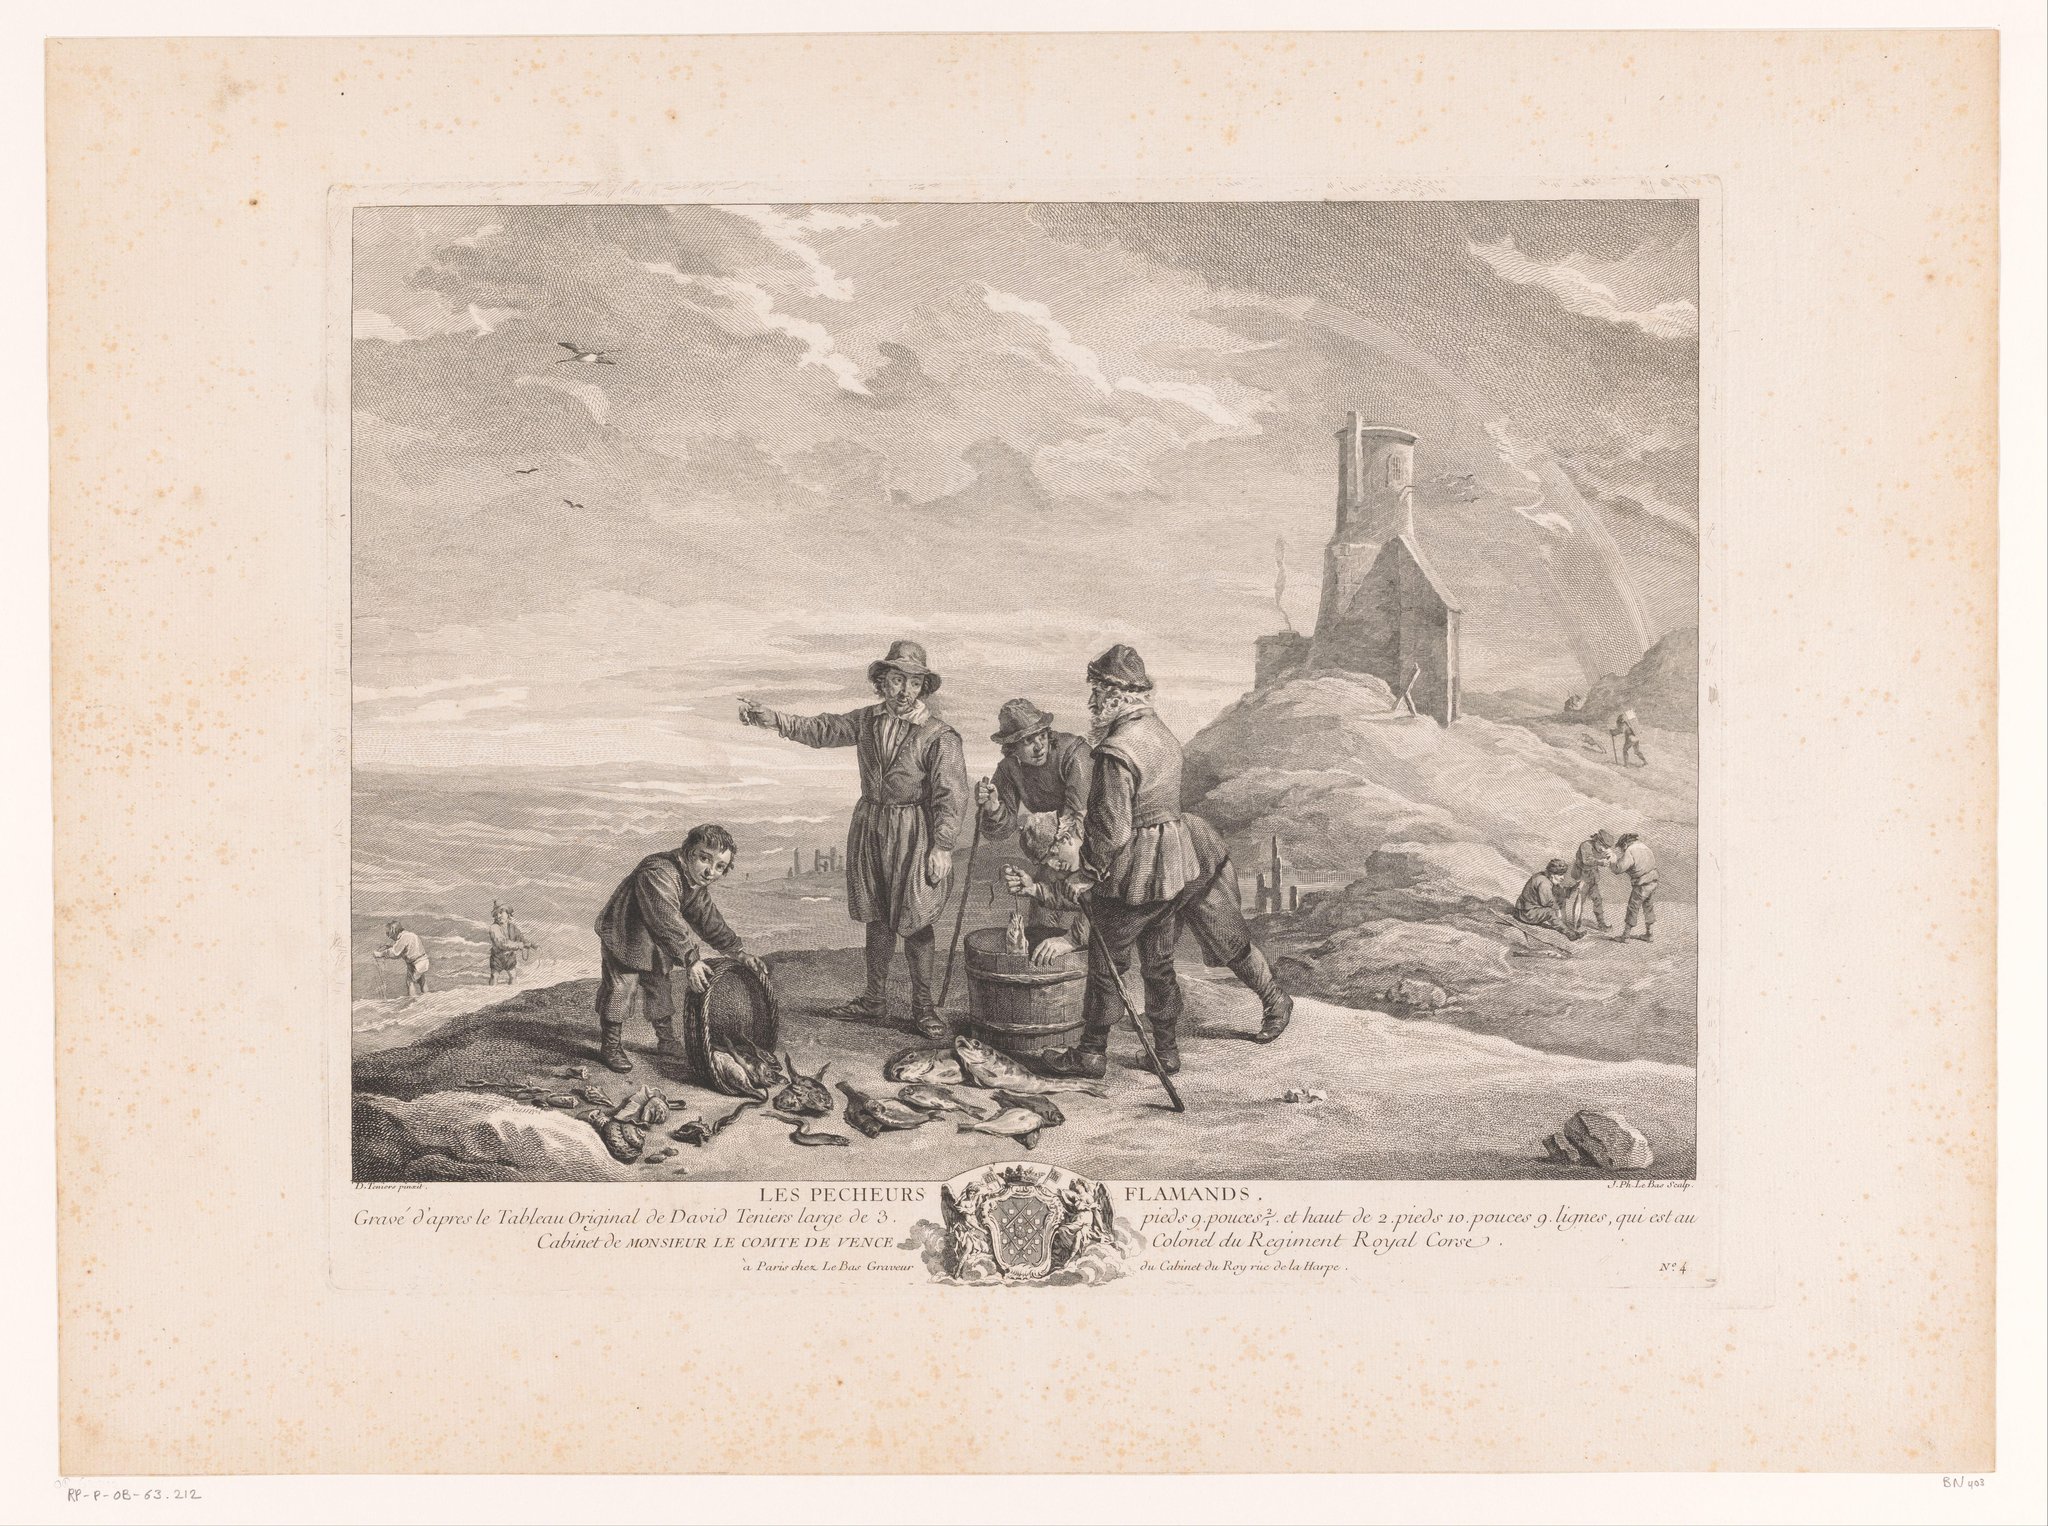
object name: print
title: Vissers met vangst aan de kust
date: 1751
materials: paper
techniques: engraving, etching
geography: paris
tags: fishes, fisherman showing catch, coast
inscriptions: collector's mark: Lugt 240